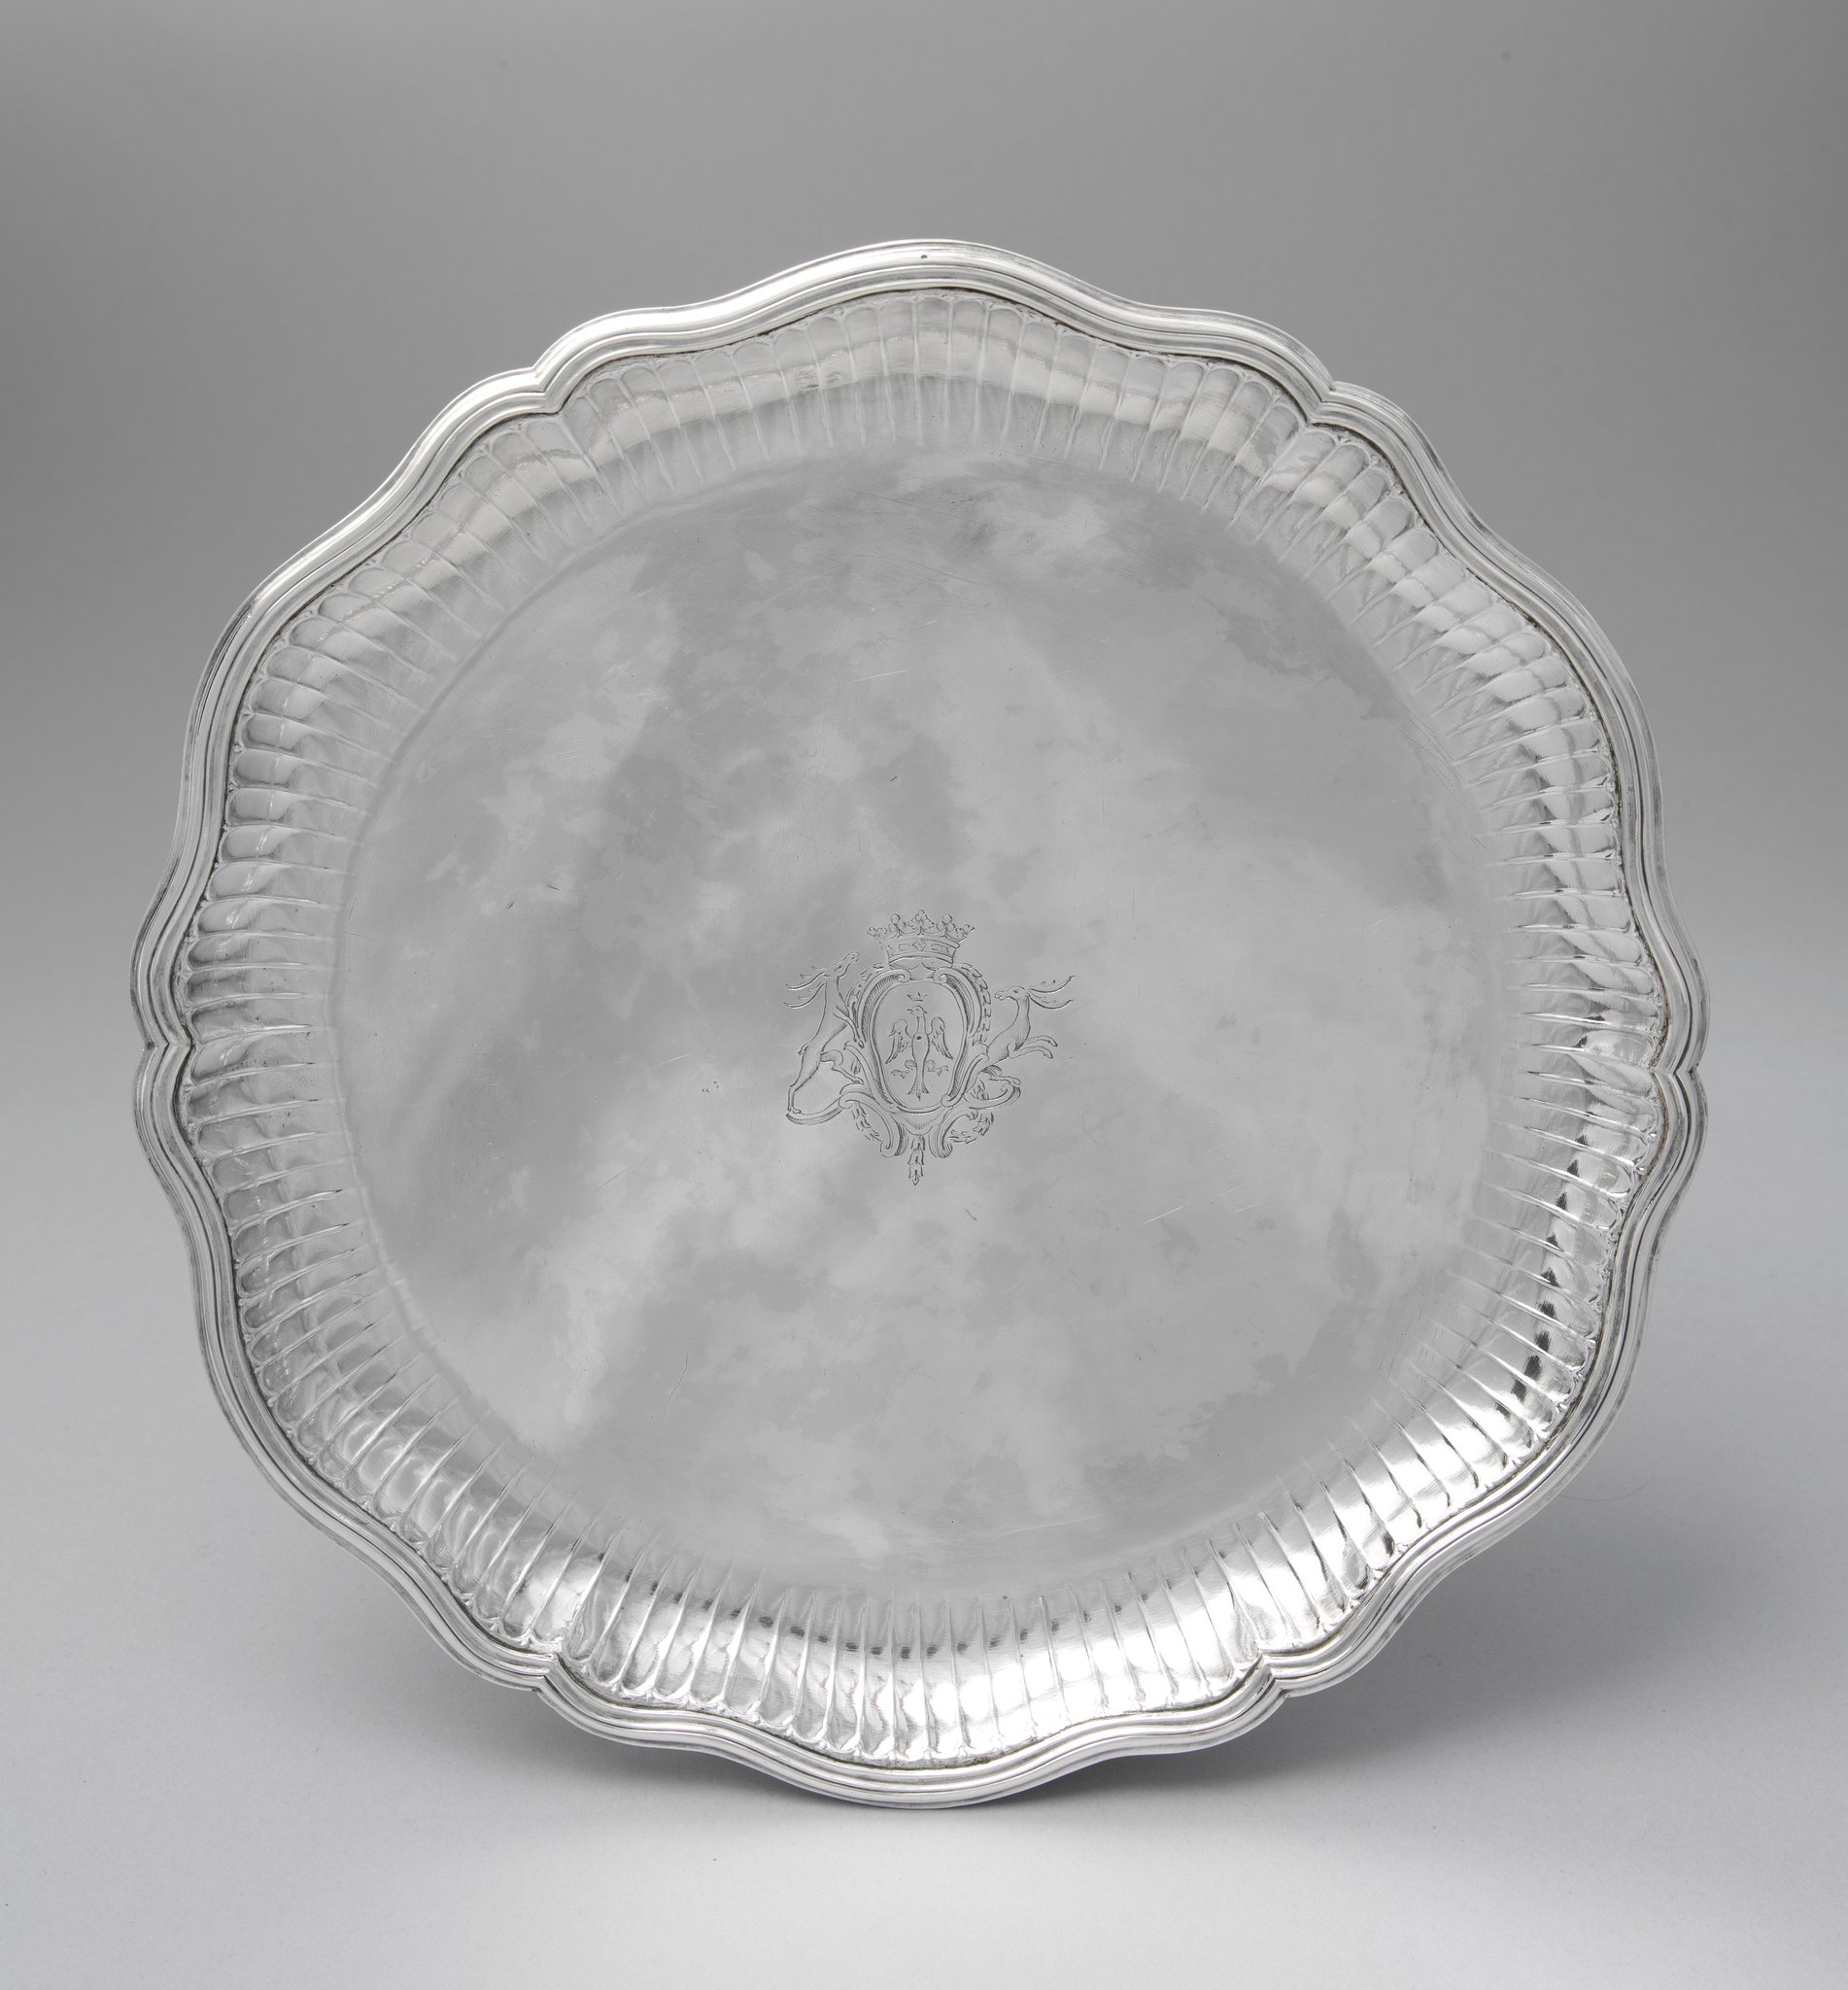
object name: dish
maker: antoine bertrand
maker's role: maker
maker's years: 1729-1789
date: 1759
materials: silver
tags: coat of arms